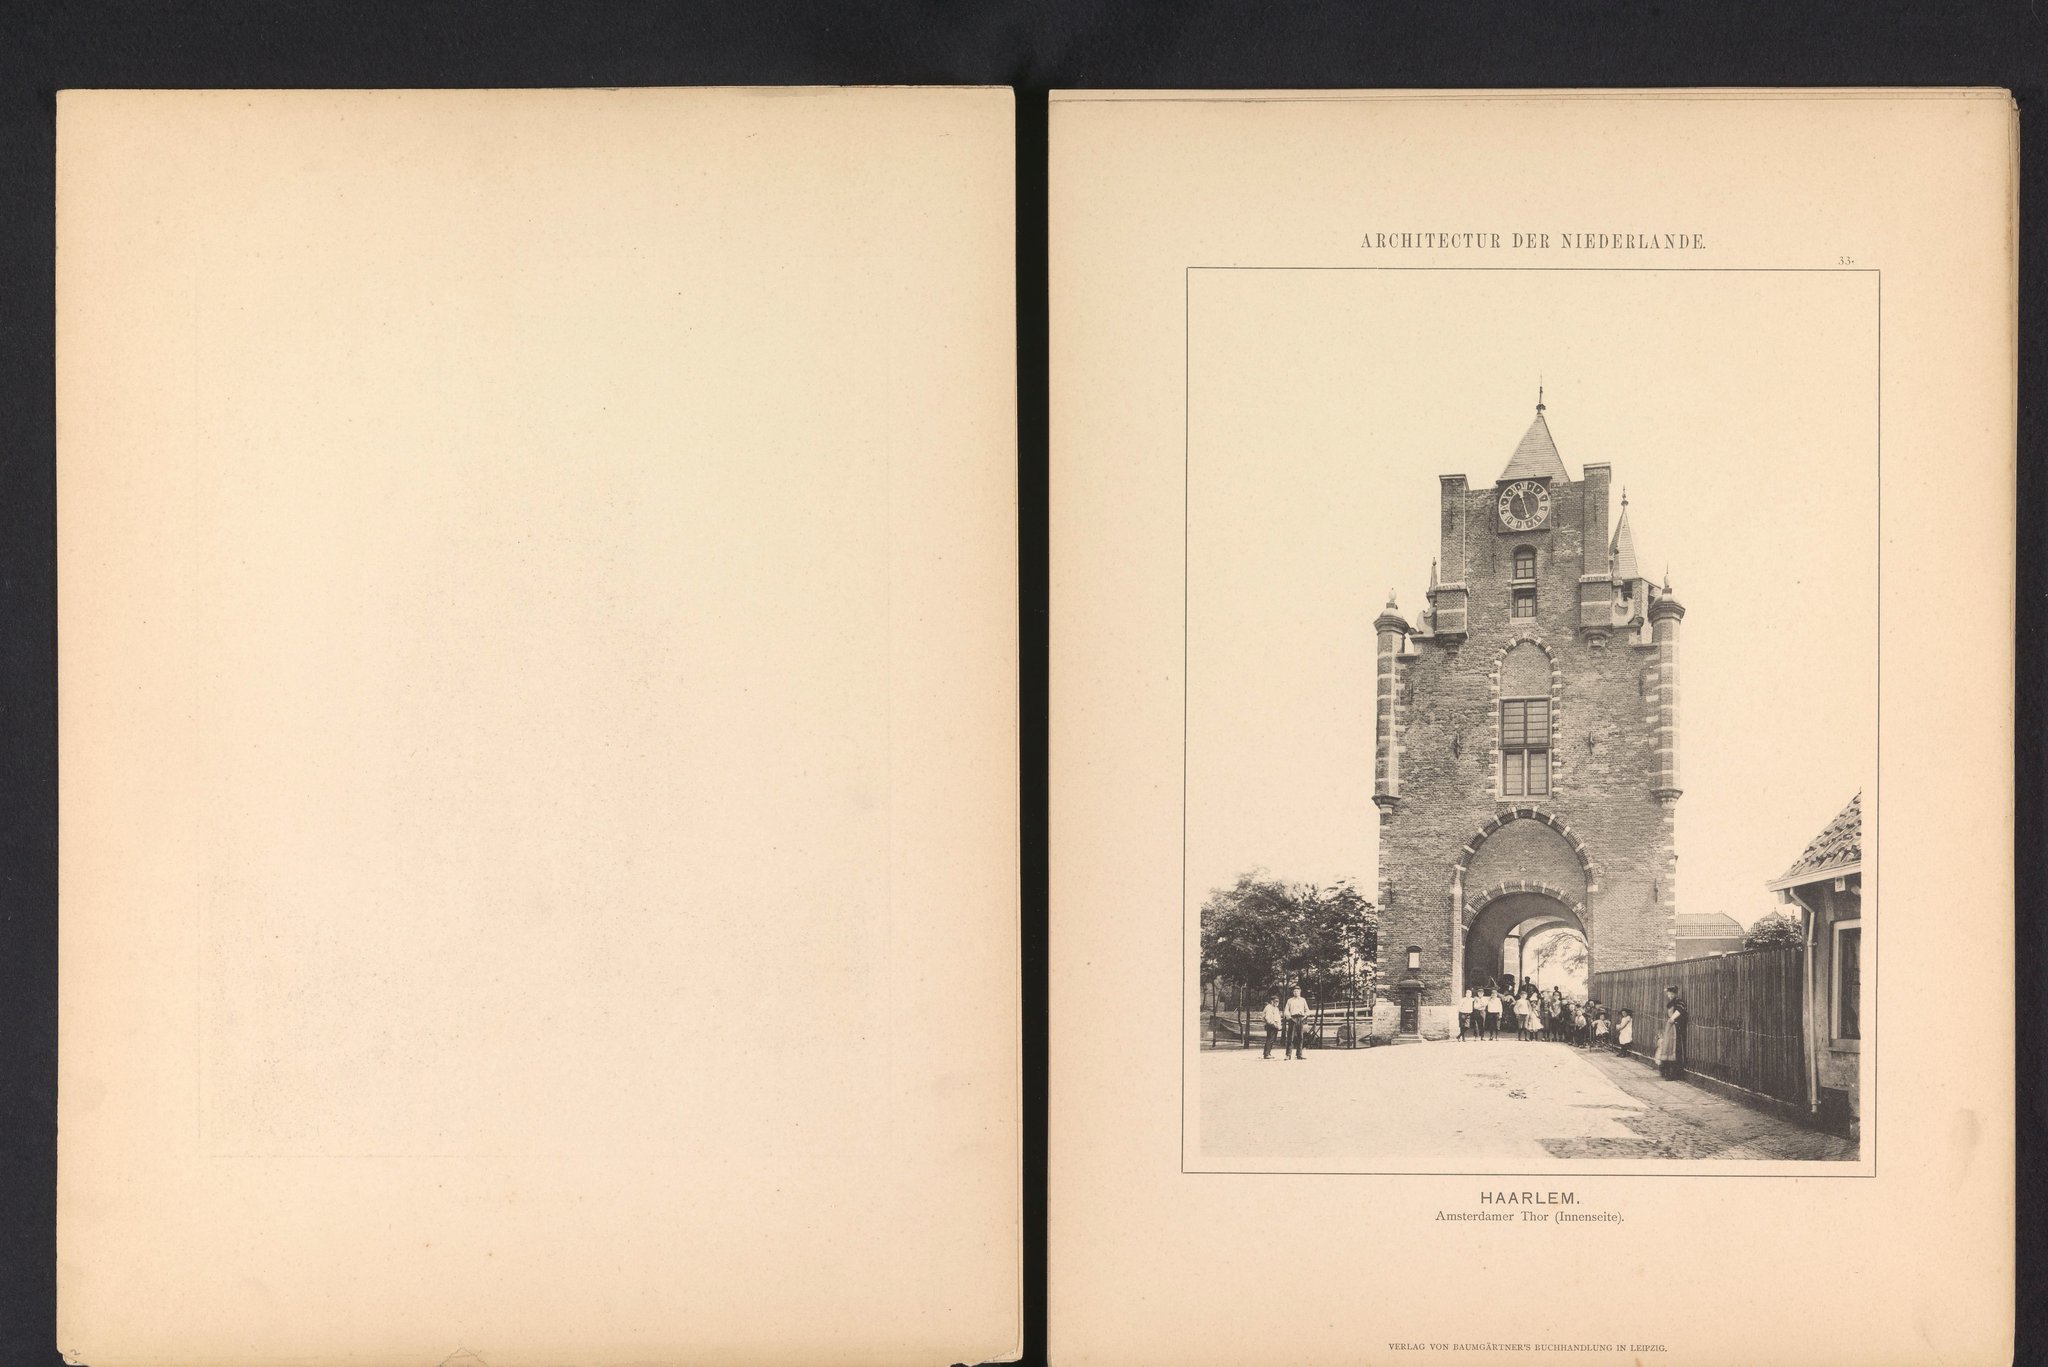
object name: page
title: Architectur der Niederlande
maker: Anonymous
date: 1884-1894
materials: paper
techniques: photograph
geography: leipzig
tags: city-gate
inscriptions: number: ‘33.’